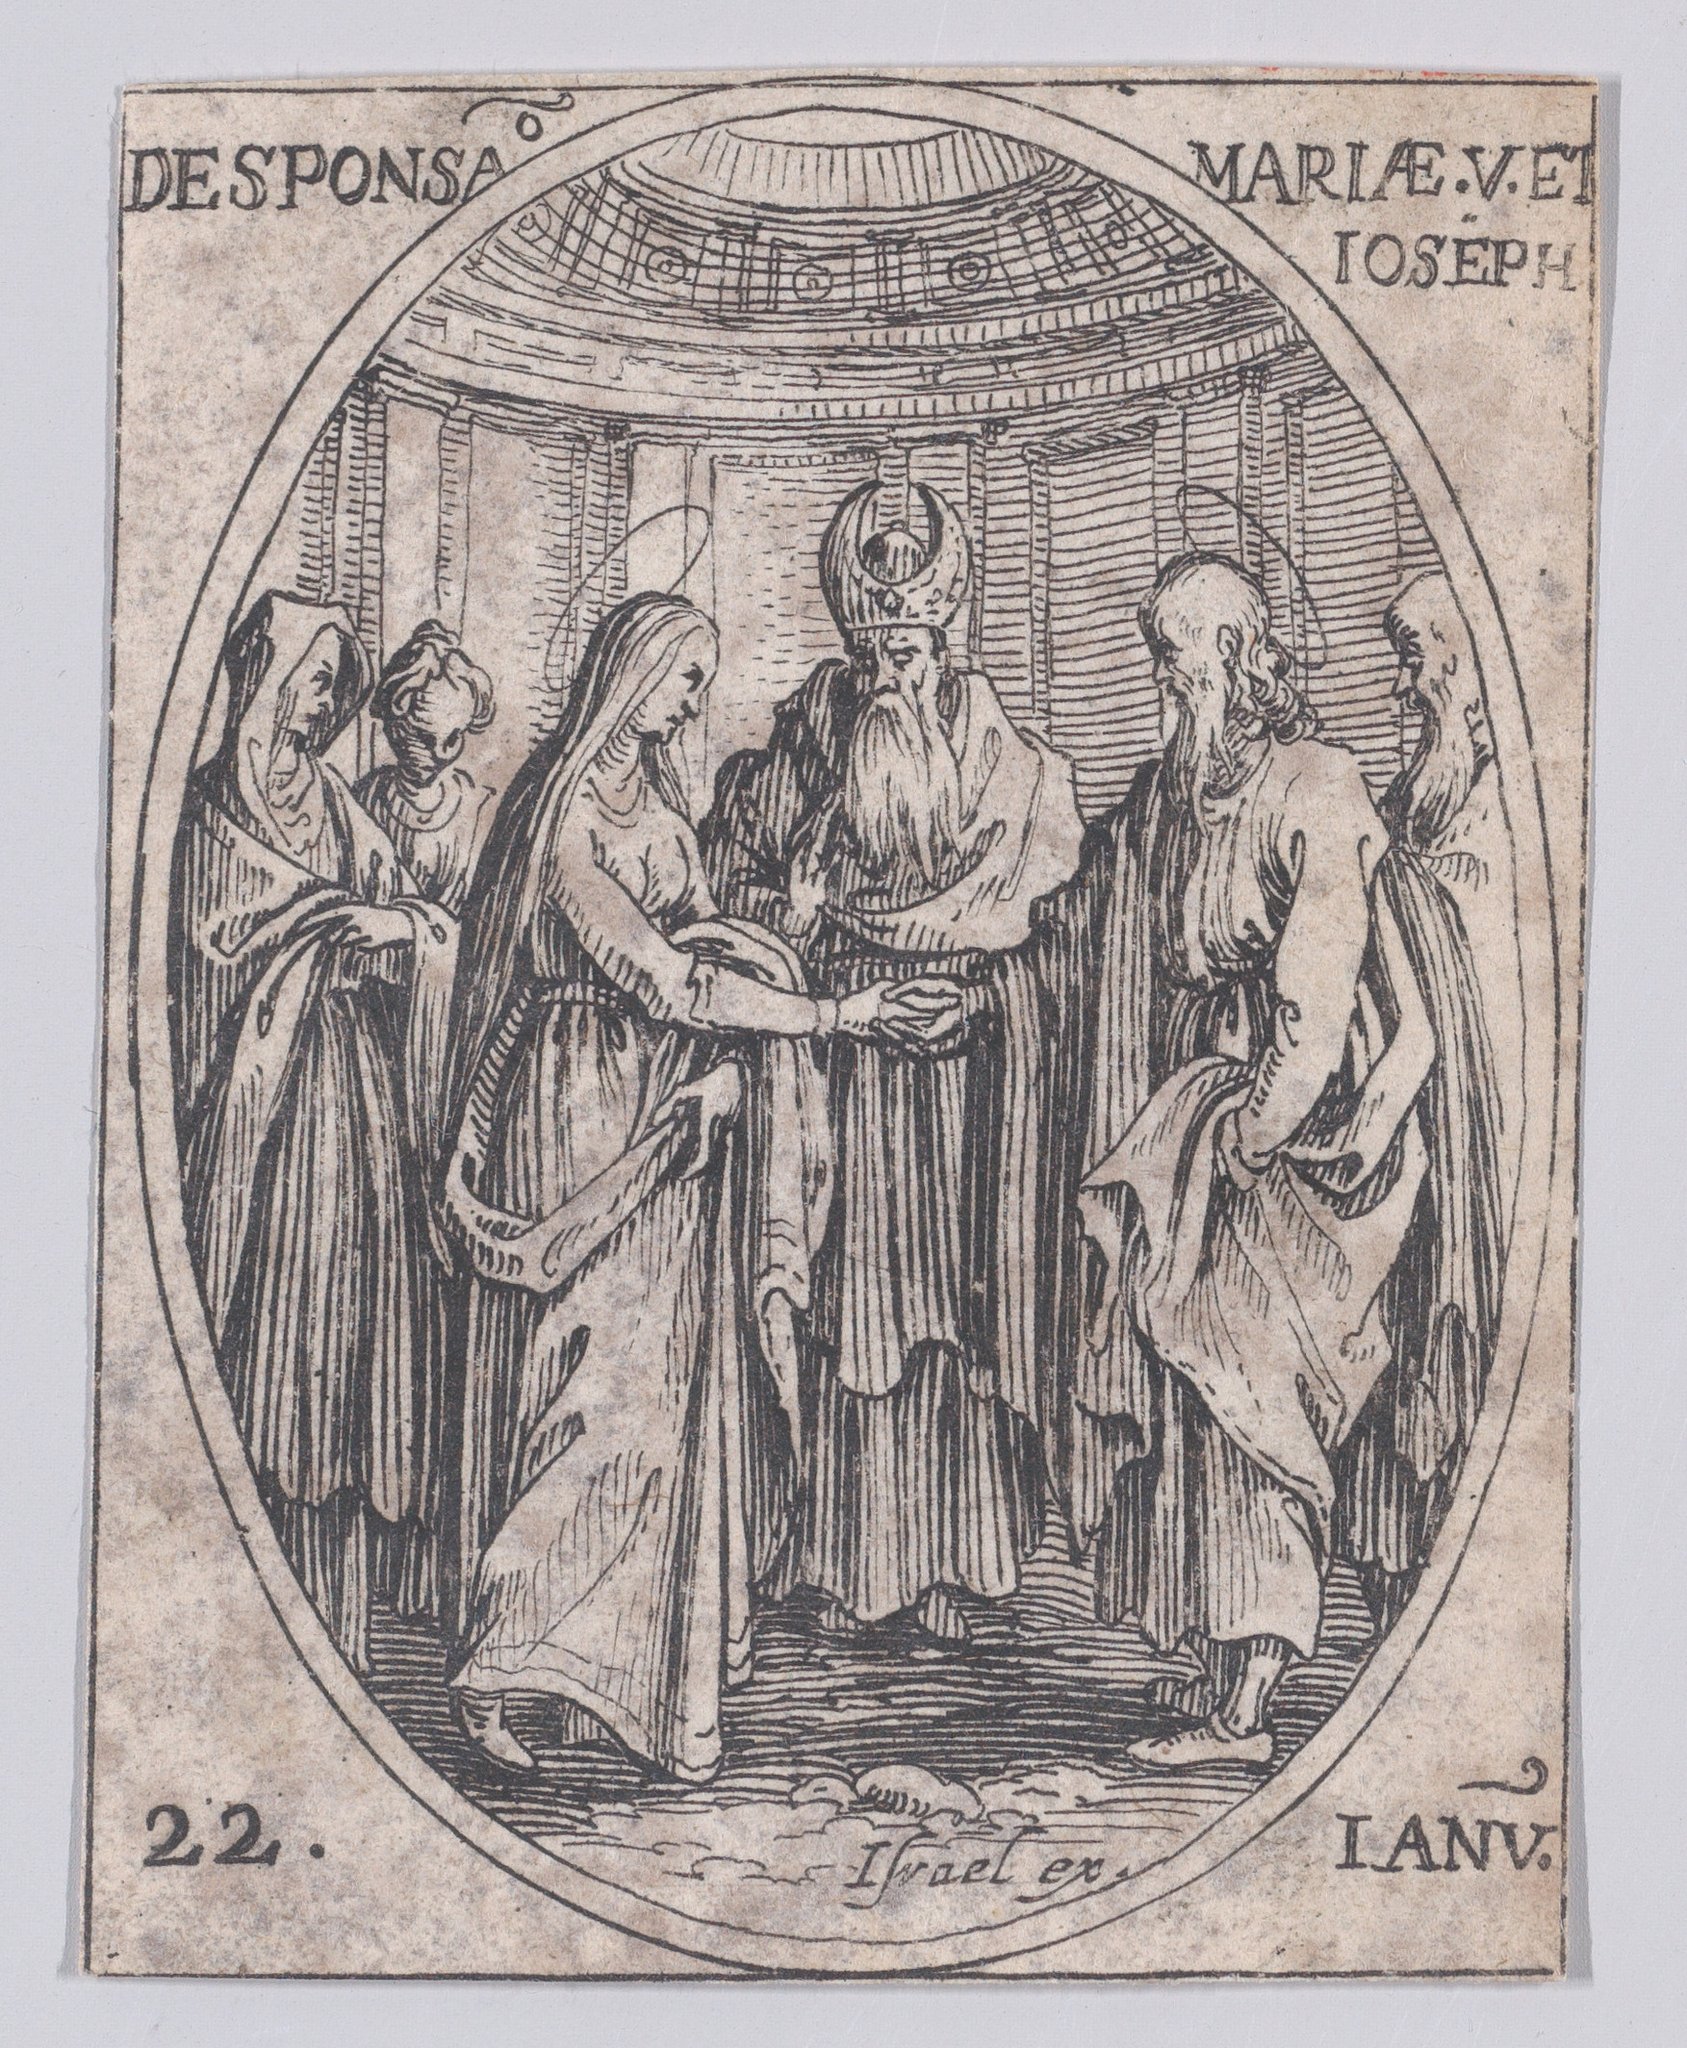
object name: print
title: Le Mariage de la Ste. Vierge (The Marriage of the Virgin), January 22nd, from "Les Images De Tous Les Saincts et Saintes de L'Année" (Images of All of the Saints and Feast Days of the Year)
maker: jacques callot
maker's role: artist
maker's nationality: french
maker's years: 1592-1635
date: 1636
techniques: etching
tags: virgin mary,joseph,marriage of the virgin